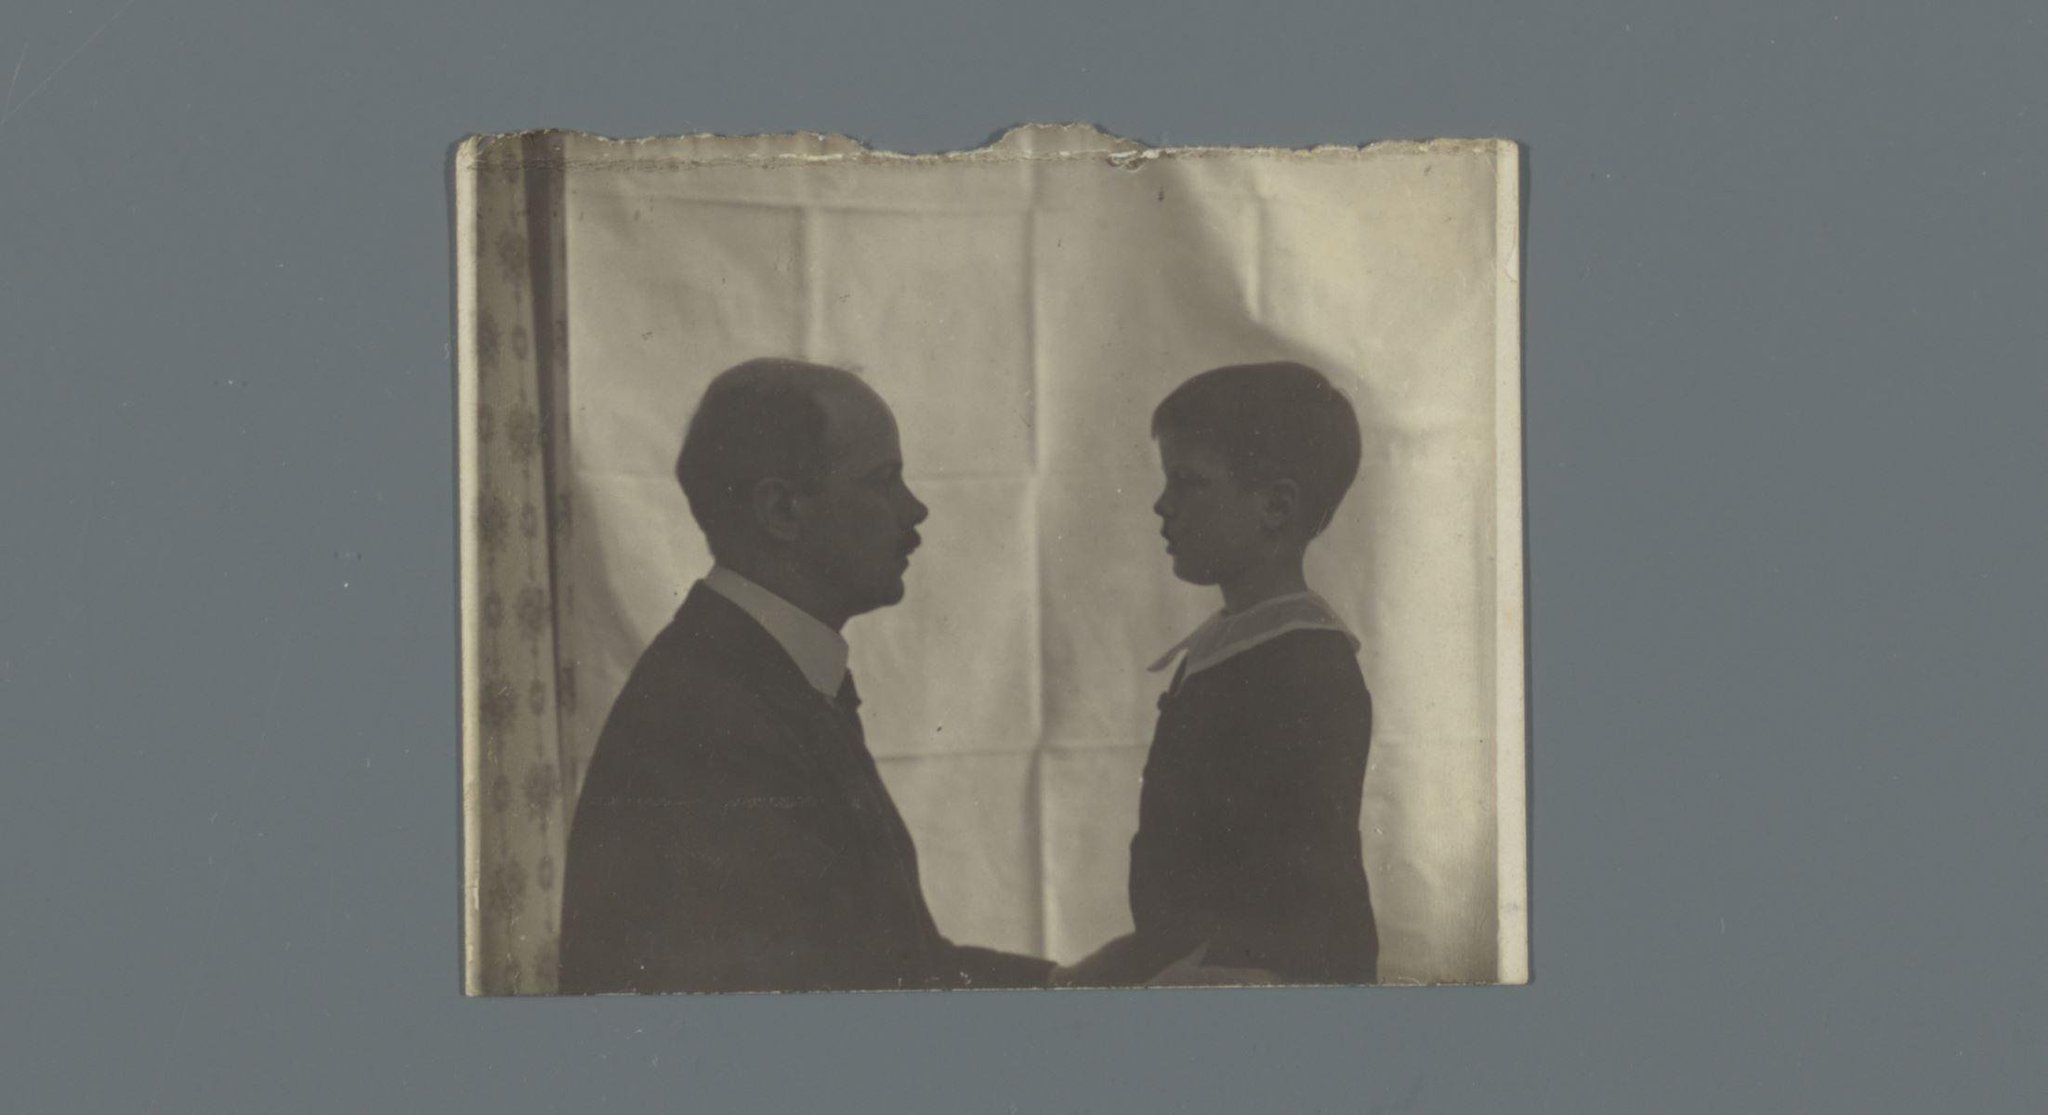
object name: photograph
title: Profielportret van Henk met zijn zoon Cay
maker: hendrik herman van den berg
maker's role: amateurfotograaf, jurist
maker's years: 1875-1944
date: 1912-1920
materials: photographic support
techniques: gelatin silver print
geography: netherlands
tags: historical persons (portraits and scenes from the life), amsterdam